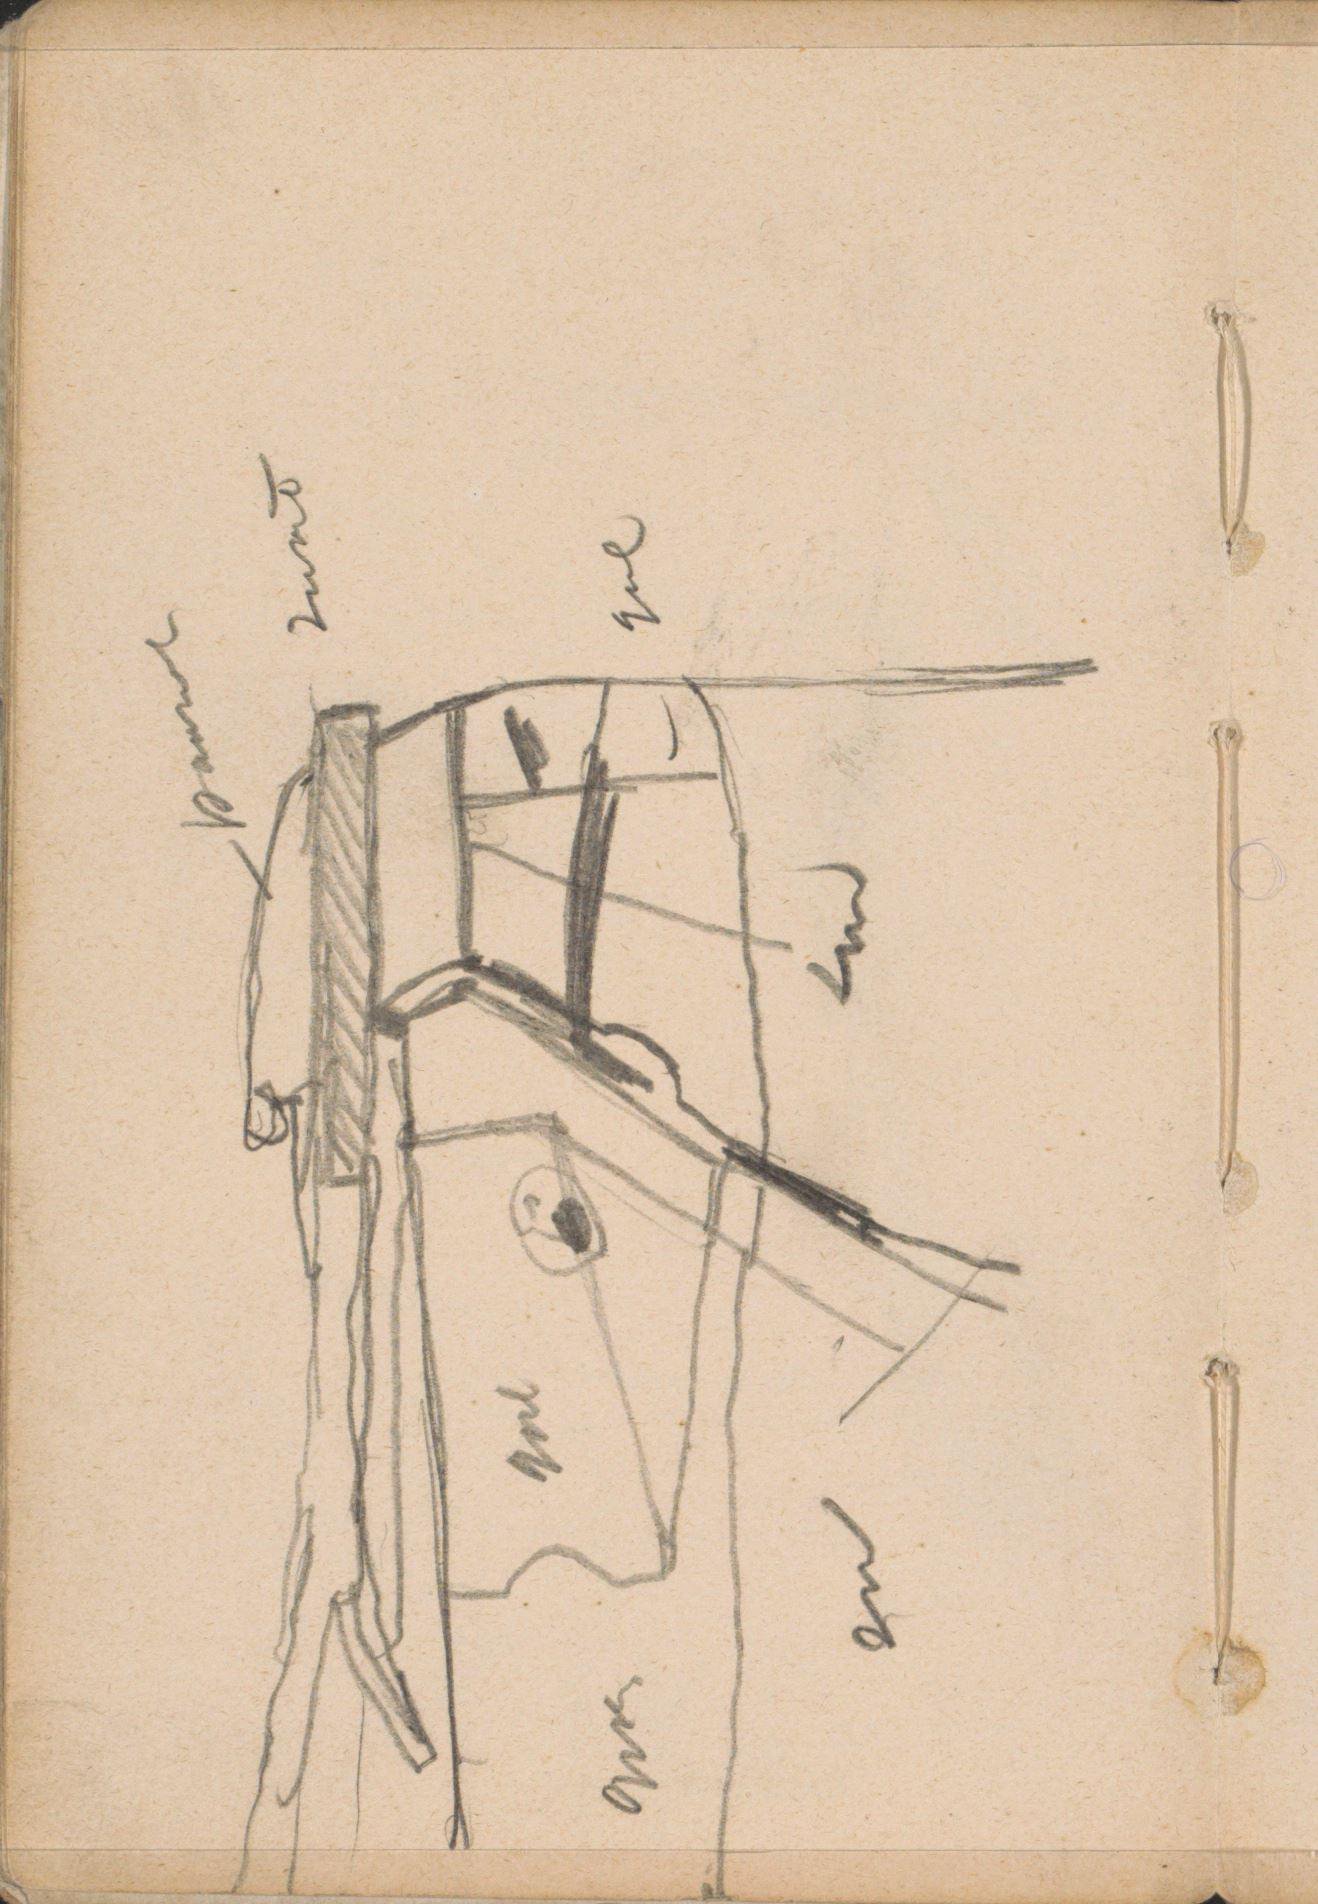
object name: sketchbook leaf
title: Studie, mogelijk van een boot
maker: george hendrik breitner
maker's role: draughtsman, painter, print maker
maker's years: 1857-1923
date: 1903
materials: paper, pencil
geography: amsterdam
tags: ships (in general)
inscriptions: kleurnotitie, handgeschreven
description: Studie, mogelijk van een boot. Pagina 11 uit een schetsboek met 46 bladen.